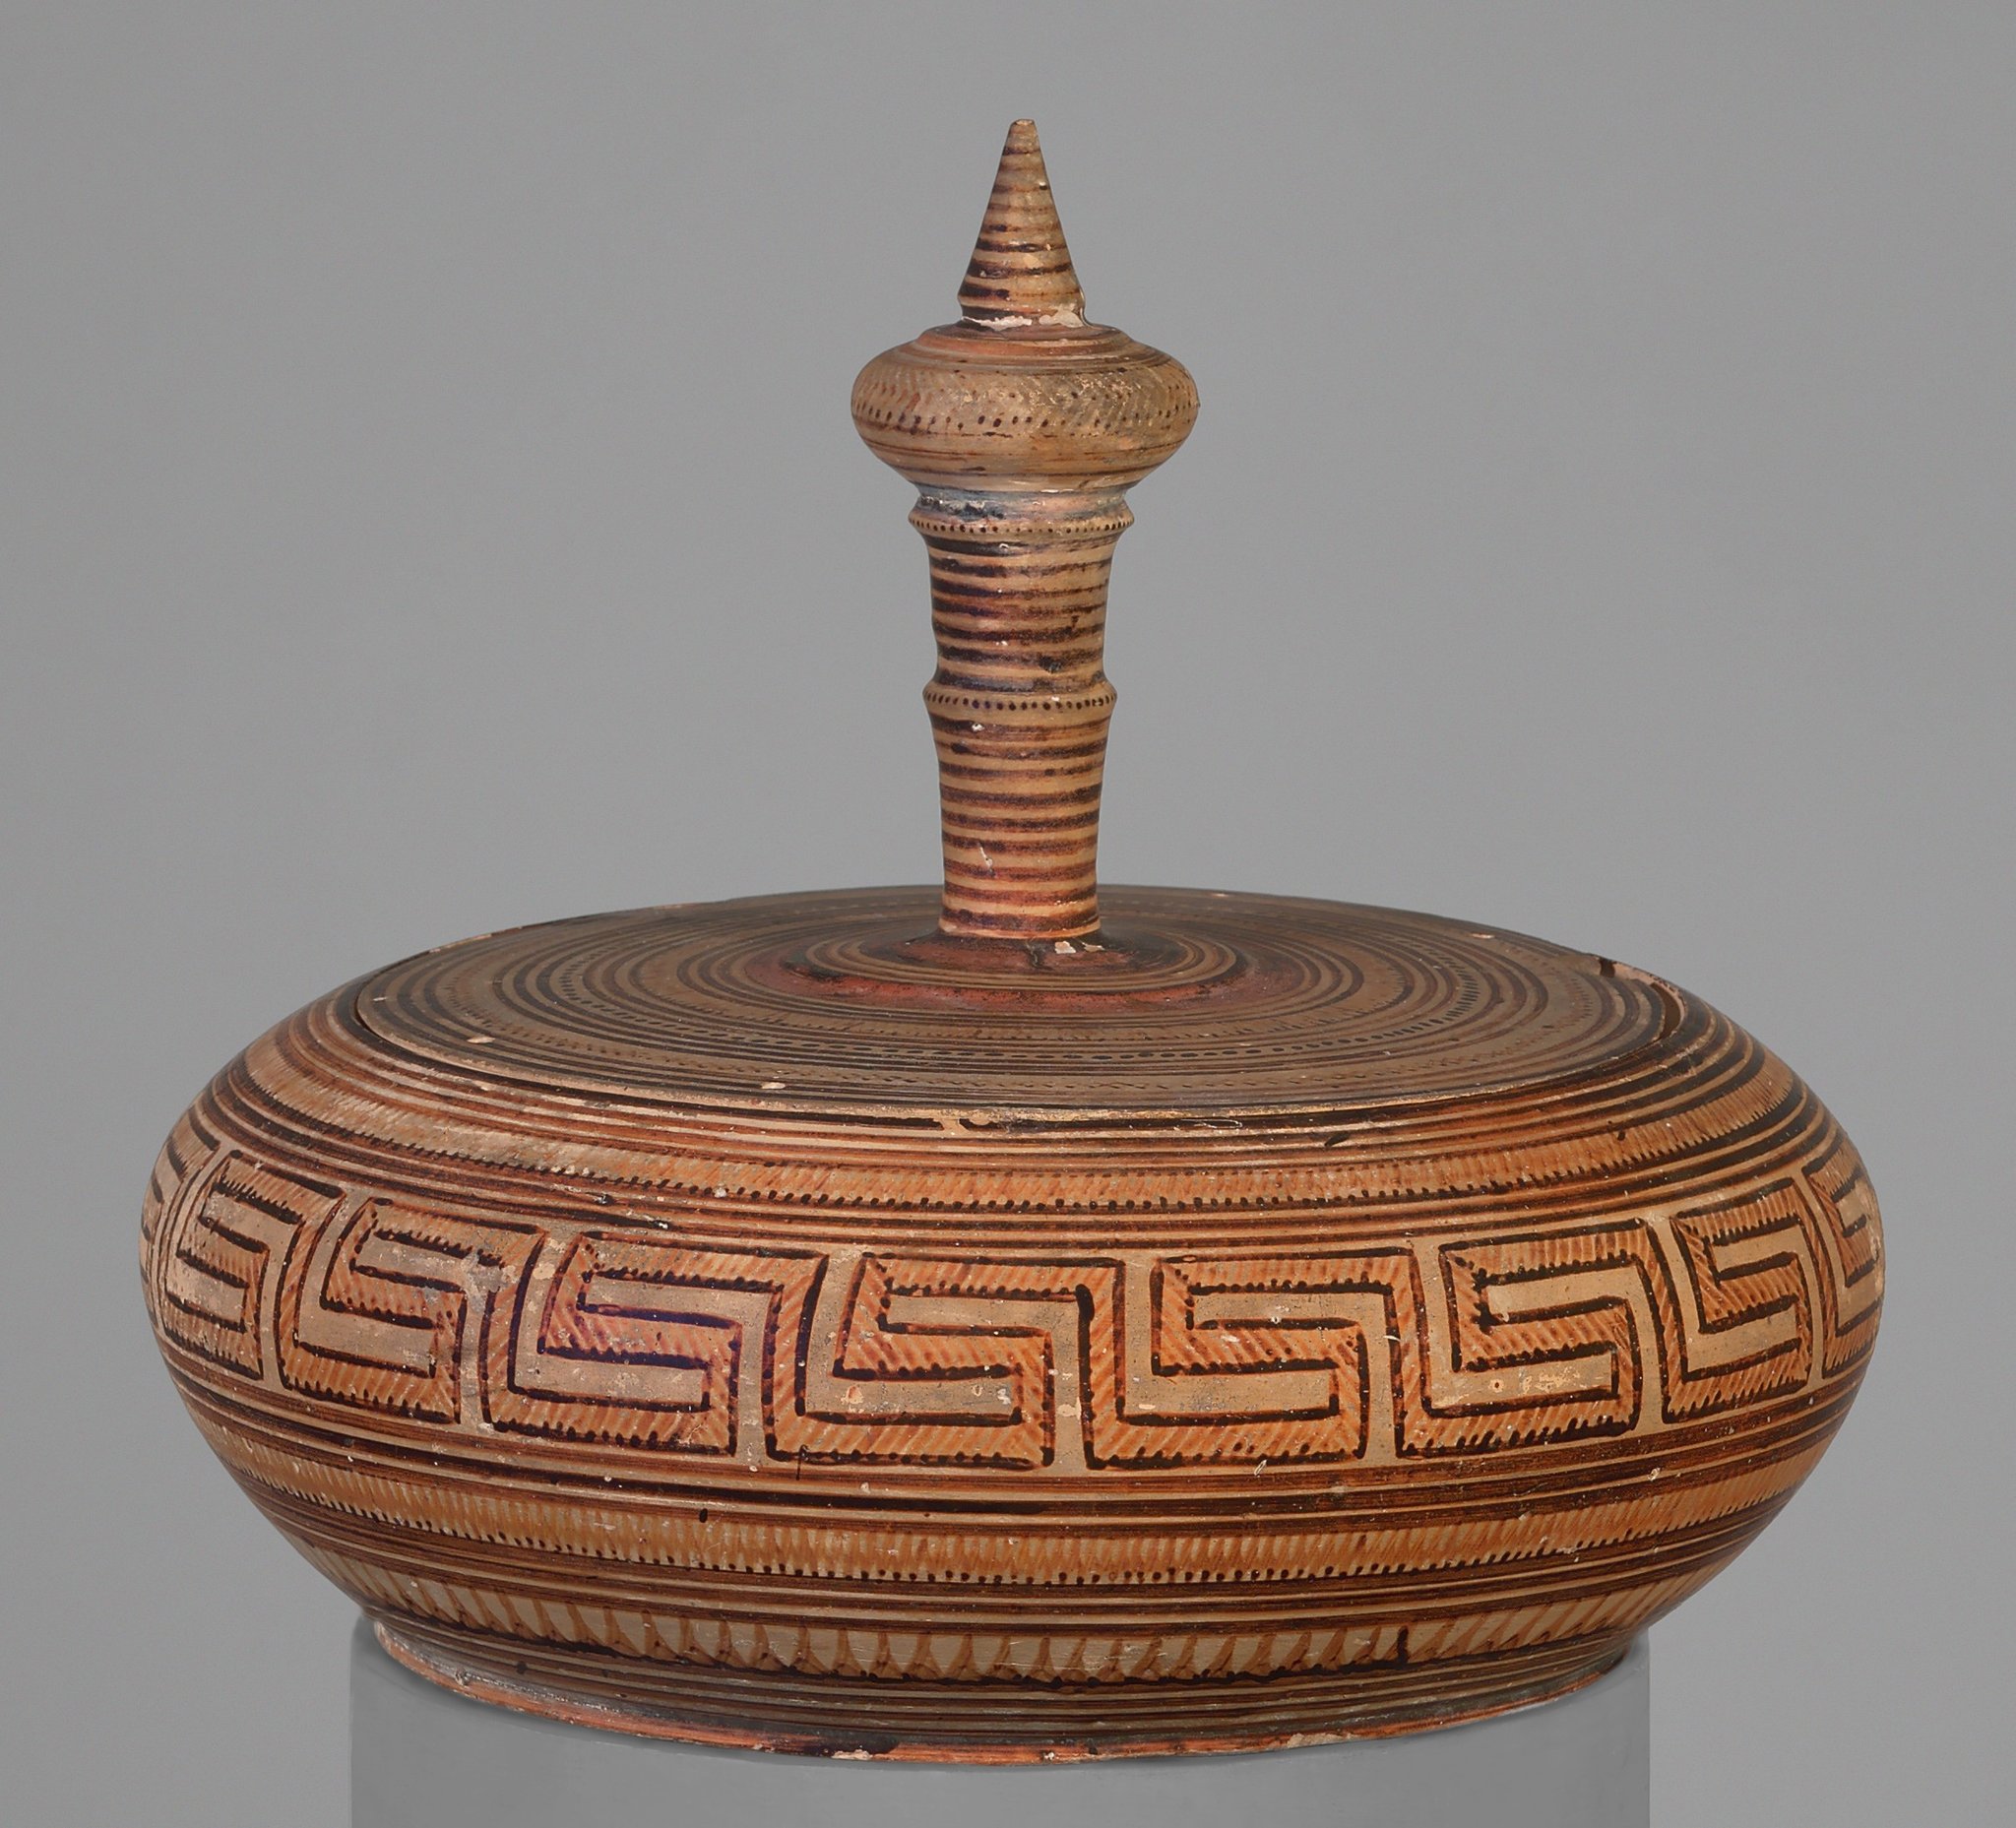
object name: pyxis with lid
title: Terracotta pyxis (box with lid)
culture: greek, attic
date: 800-760 BCE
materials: terracotta